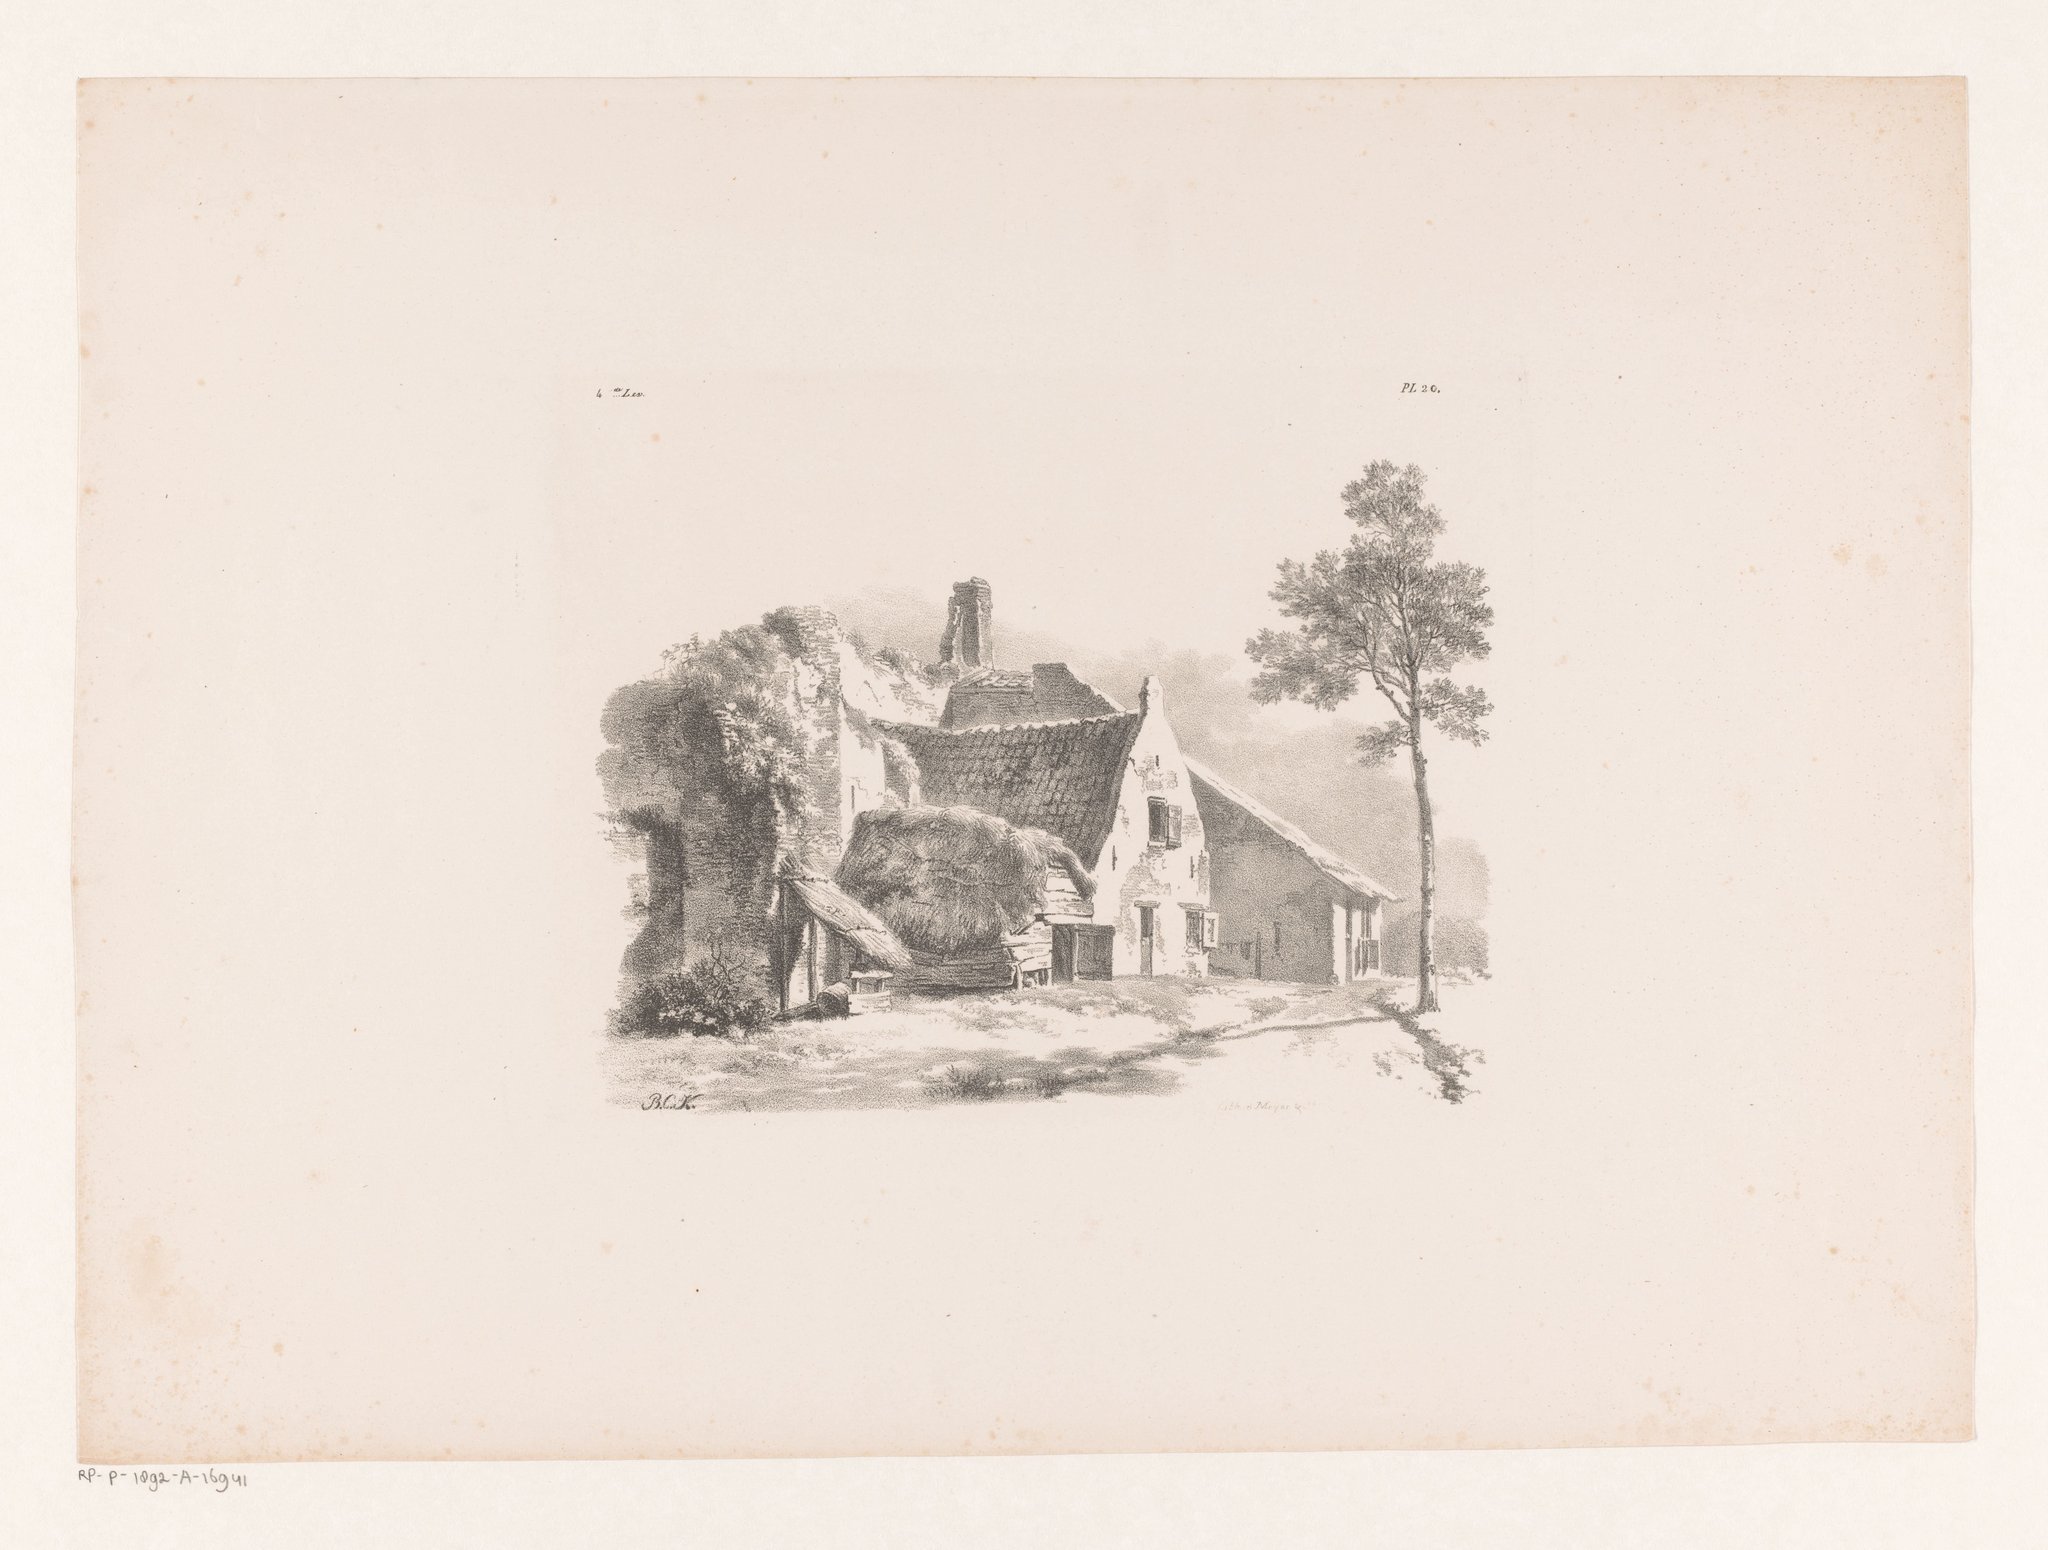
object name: print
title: Landschap studiën vierde levering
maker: barend cornelis koekkoek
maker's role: draughtsman, painter, print maker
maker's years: 1803-1862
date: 1844-1845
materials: paper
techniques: lithograph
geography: amsterdam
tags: ruin of a building ~ architecture, farm (building)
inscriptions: collector's mark: Lugt 2228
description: In 1829 en 1830 gaf Koekkoek, samen met Daiwaille, zes cahiers uit met ieder zes prenten getiteld Landschapstudiën. Deze werden gebruikt in het tekenonderwijs. Vijftien jaar later werd deze reeks, in een andere samenstelling nogmaals uitgegeven door Meyer en Comp in Amsterdam. Zie: De Bruyn Kops, 1963.